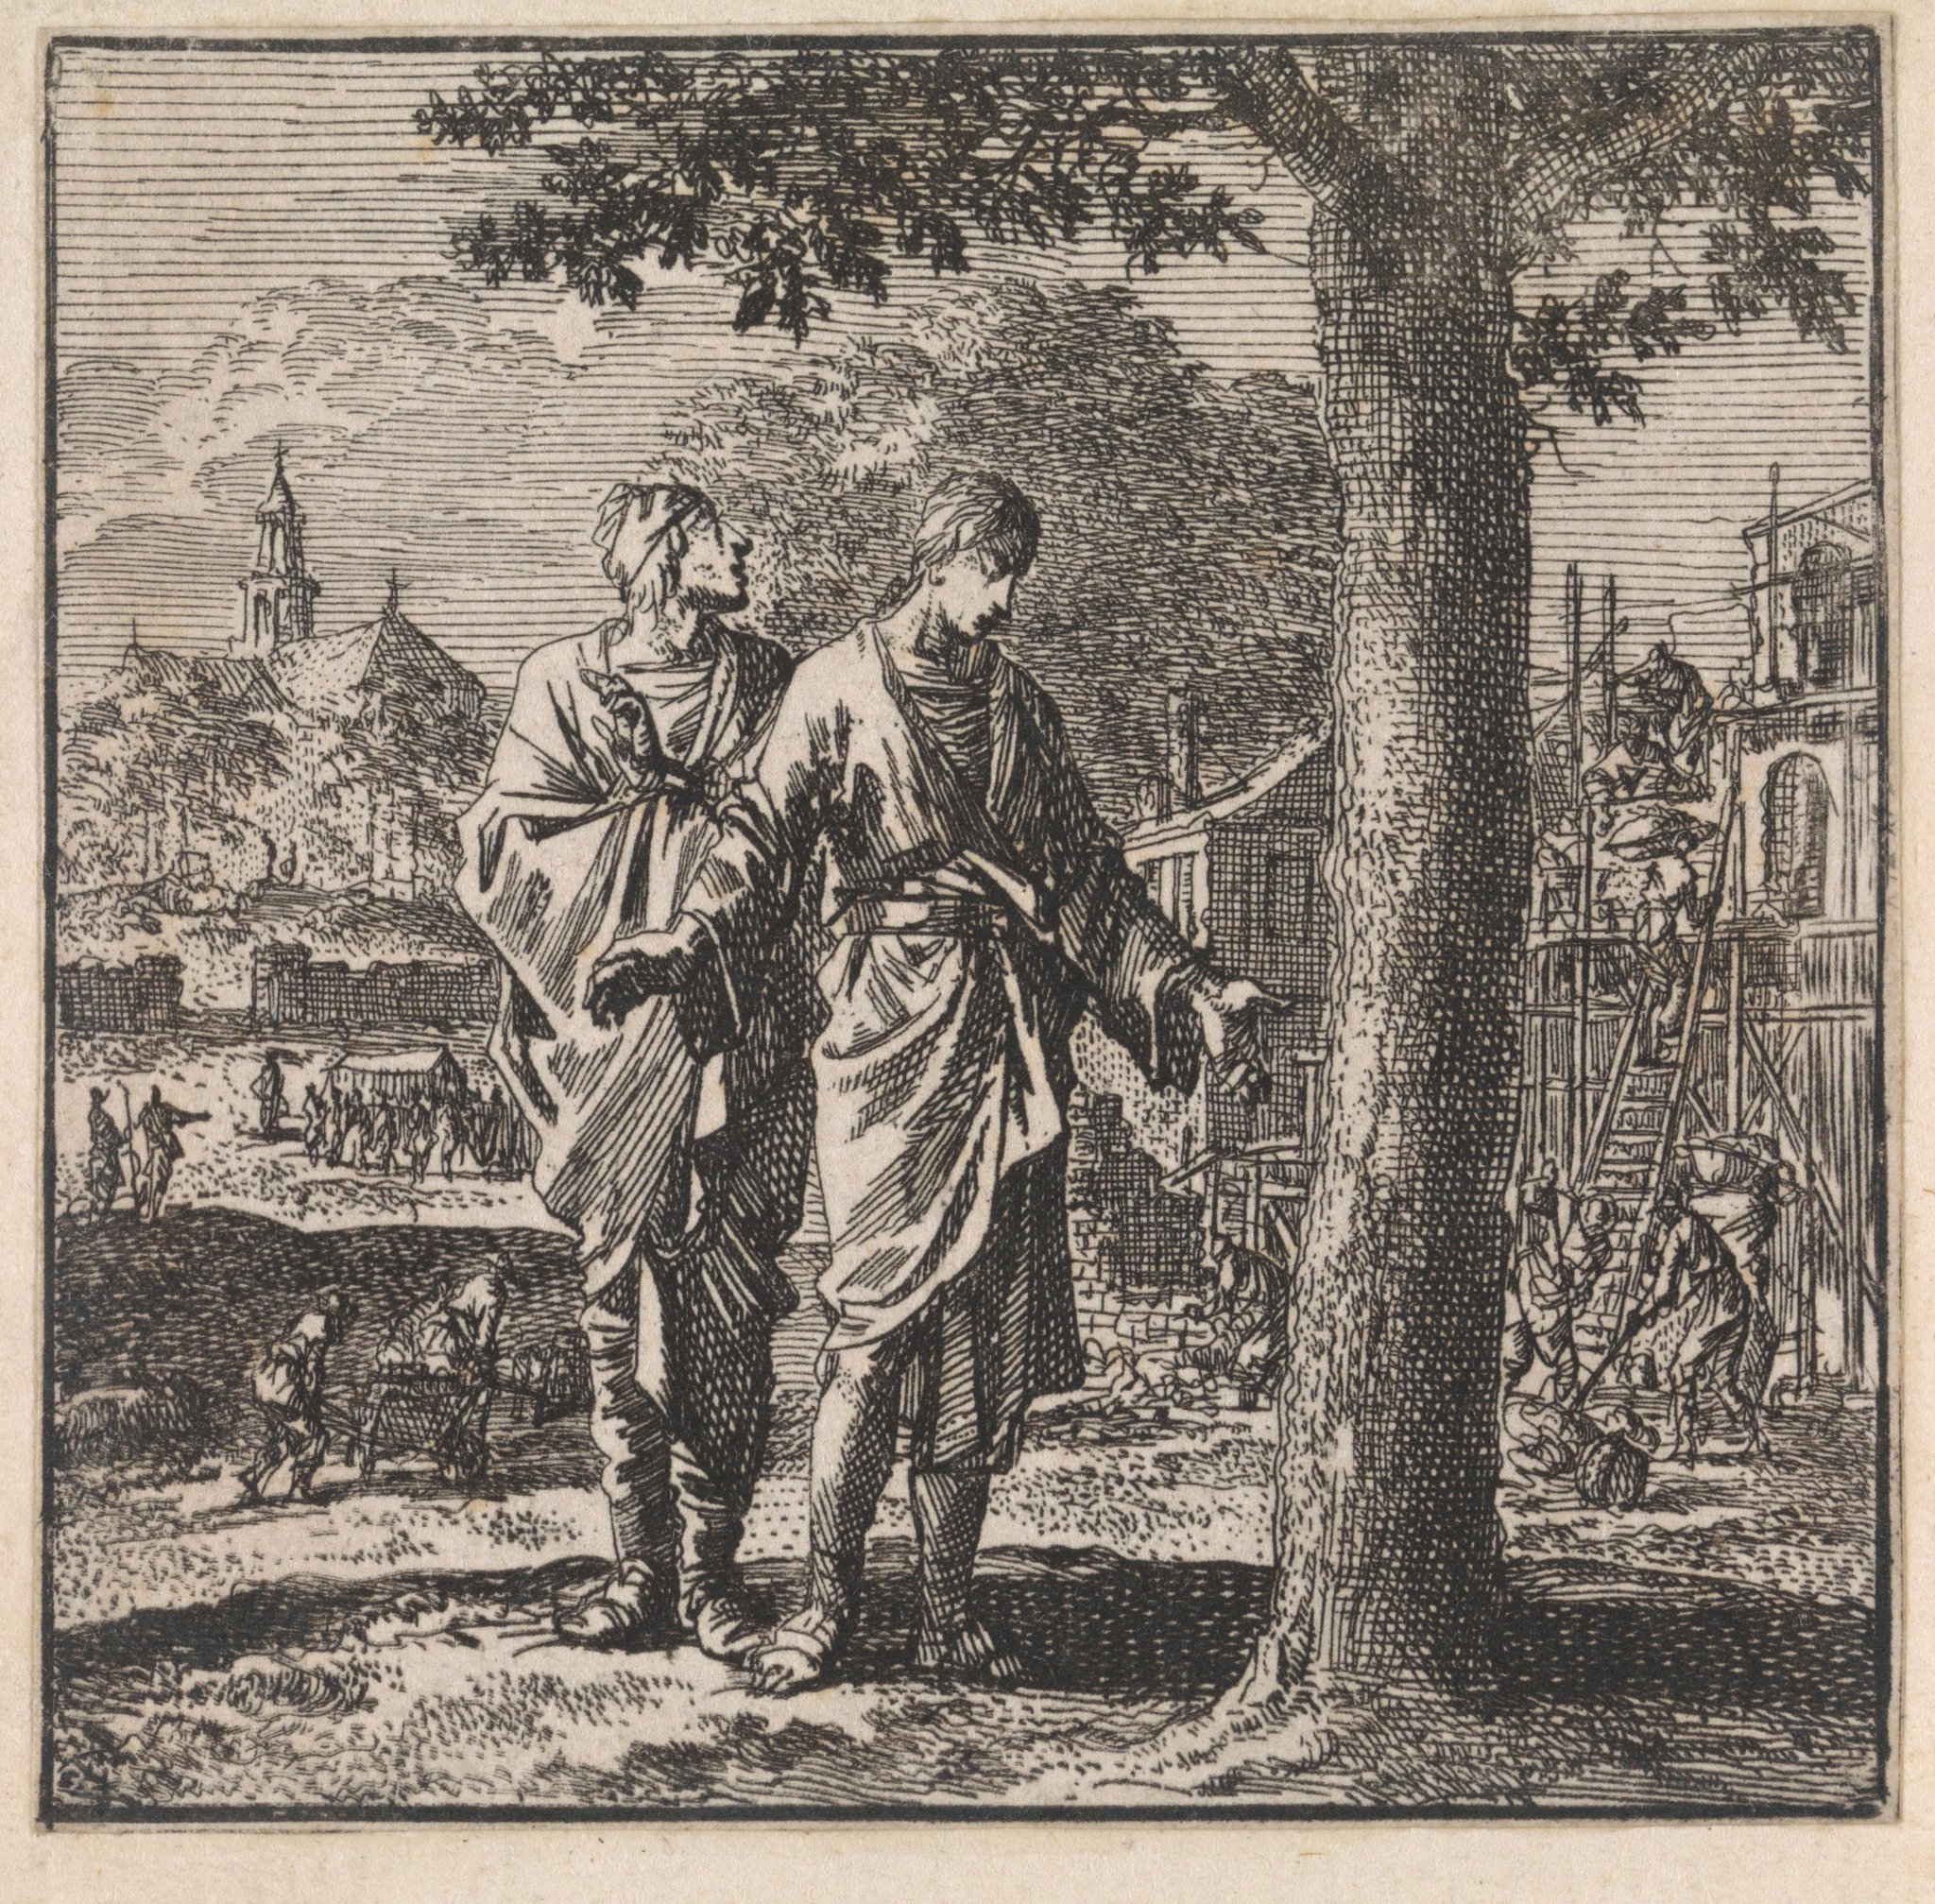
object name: print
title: Twee mannen bekijken een boom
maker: jan luyken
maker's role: draughtsman, print maker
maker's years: 1649-1712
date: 1710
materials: paper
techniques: etching, letterpress printing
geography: amsterdam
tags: trees, cortege, funeral procession, housing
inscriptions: collector's mark: Lugt 240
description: Illustratie uit: Luyken, Jan. De onwaardige wereld, vertoond in vyftig zinnebeelden, met godlyke spreuken en stichtelyke verzen. Amsterdam: Pieter Arentsz. II (wed.) en Cornelis van der Sys, 1710, p. 54.